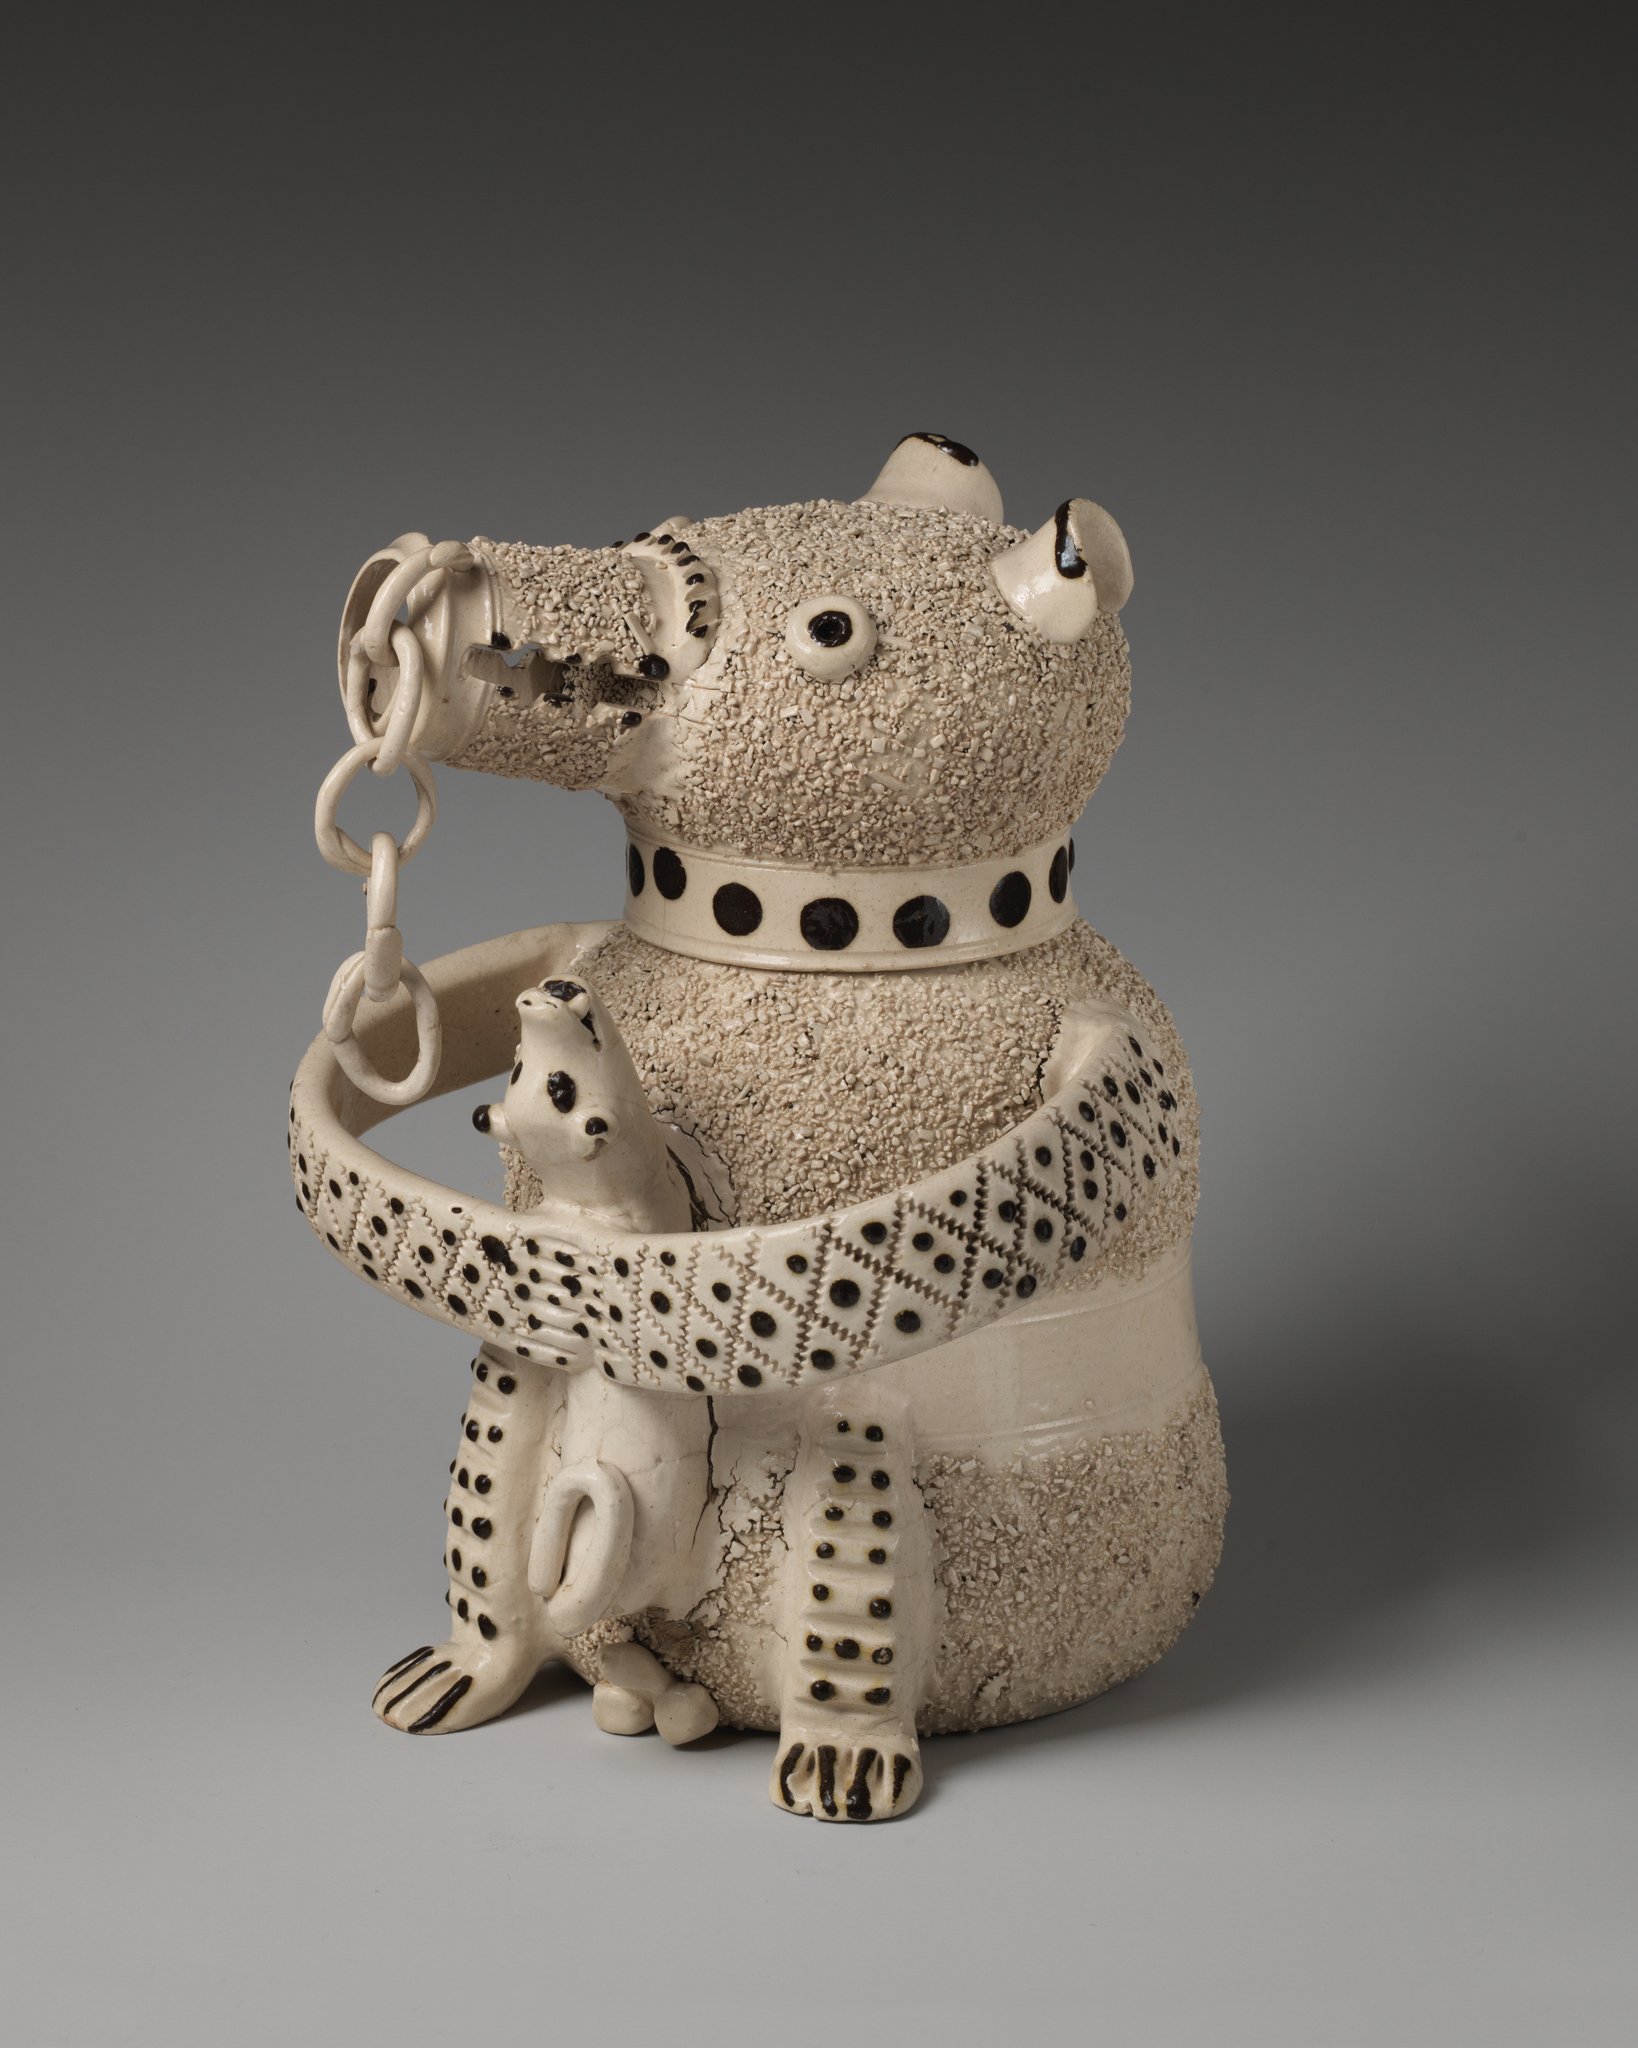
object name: jug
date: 1740-1750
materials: stoneware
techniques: salt glaze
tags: animals